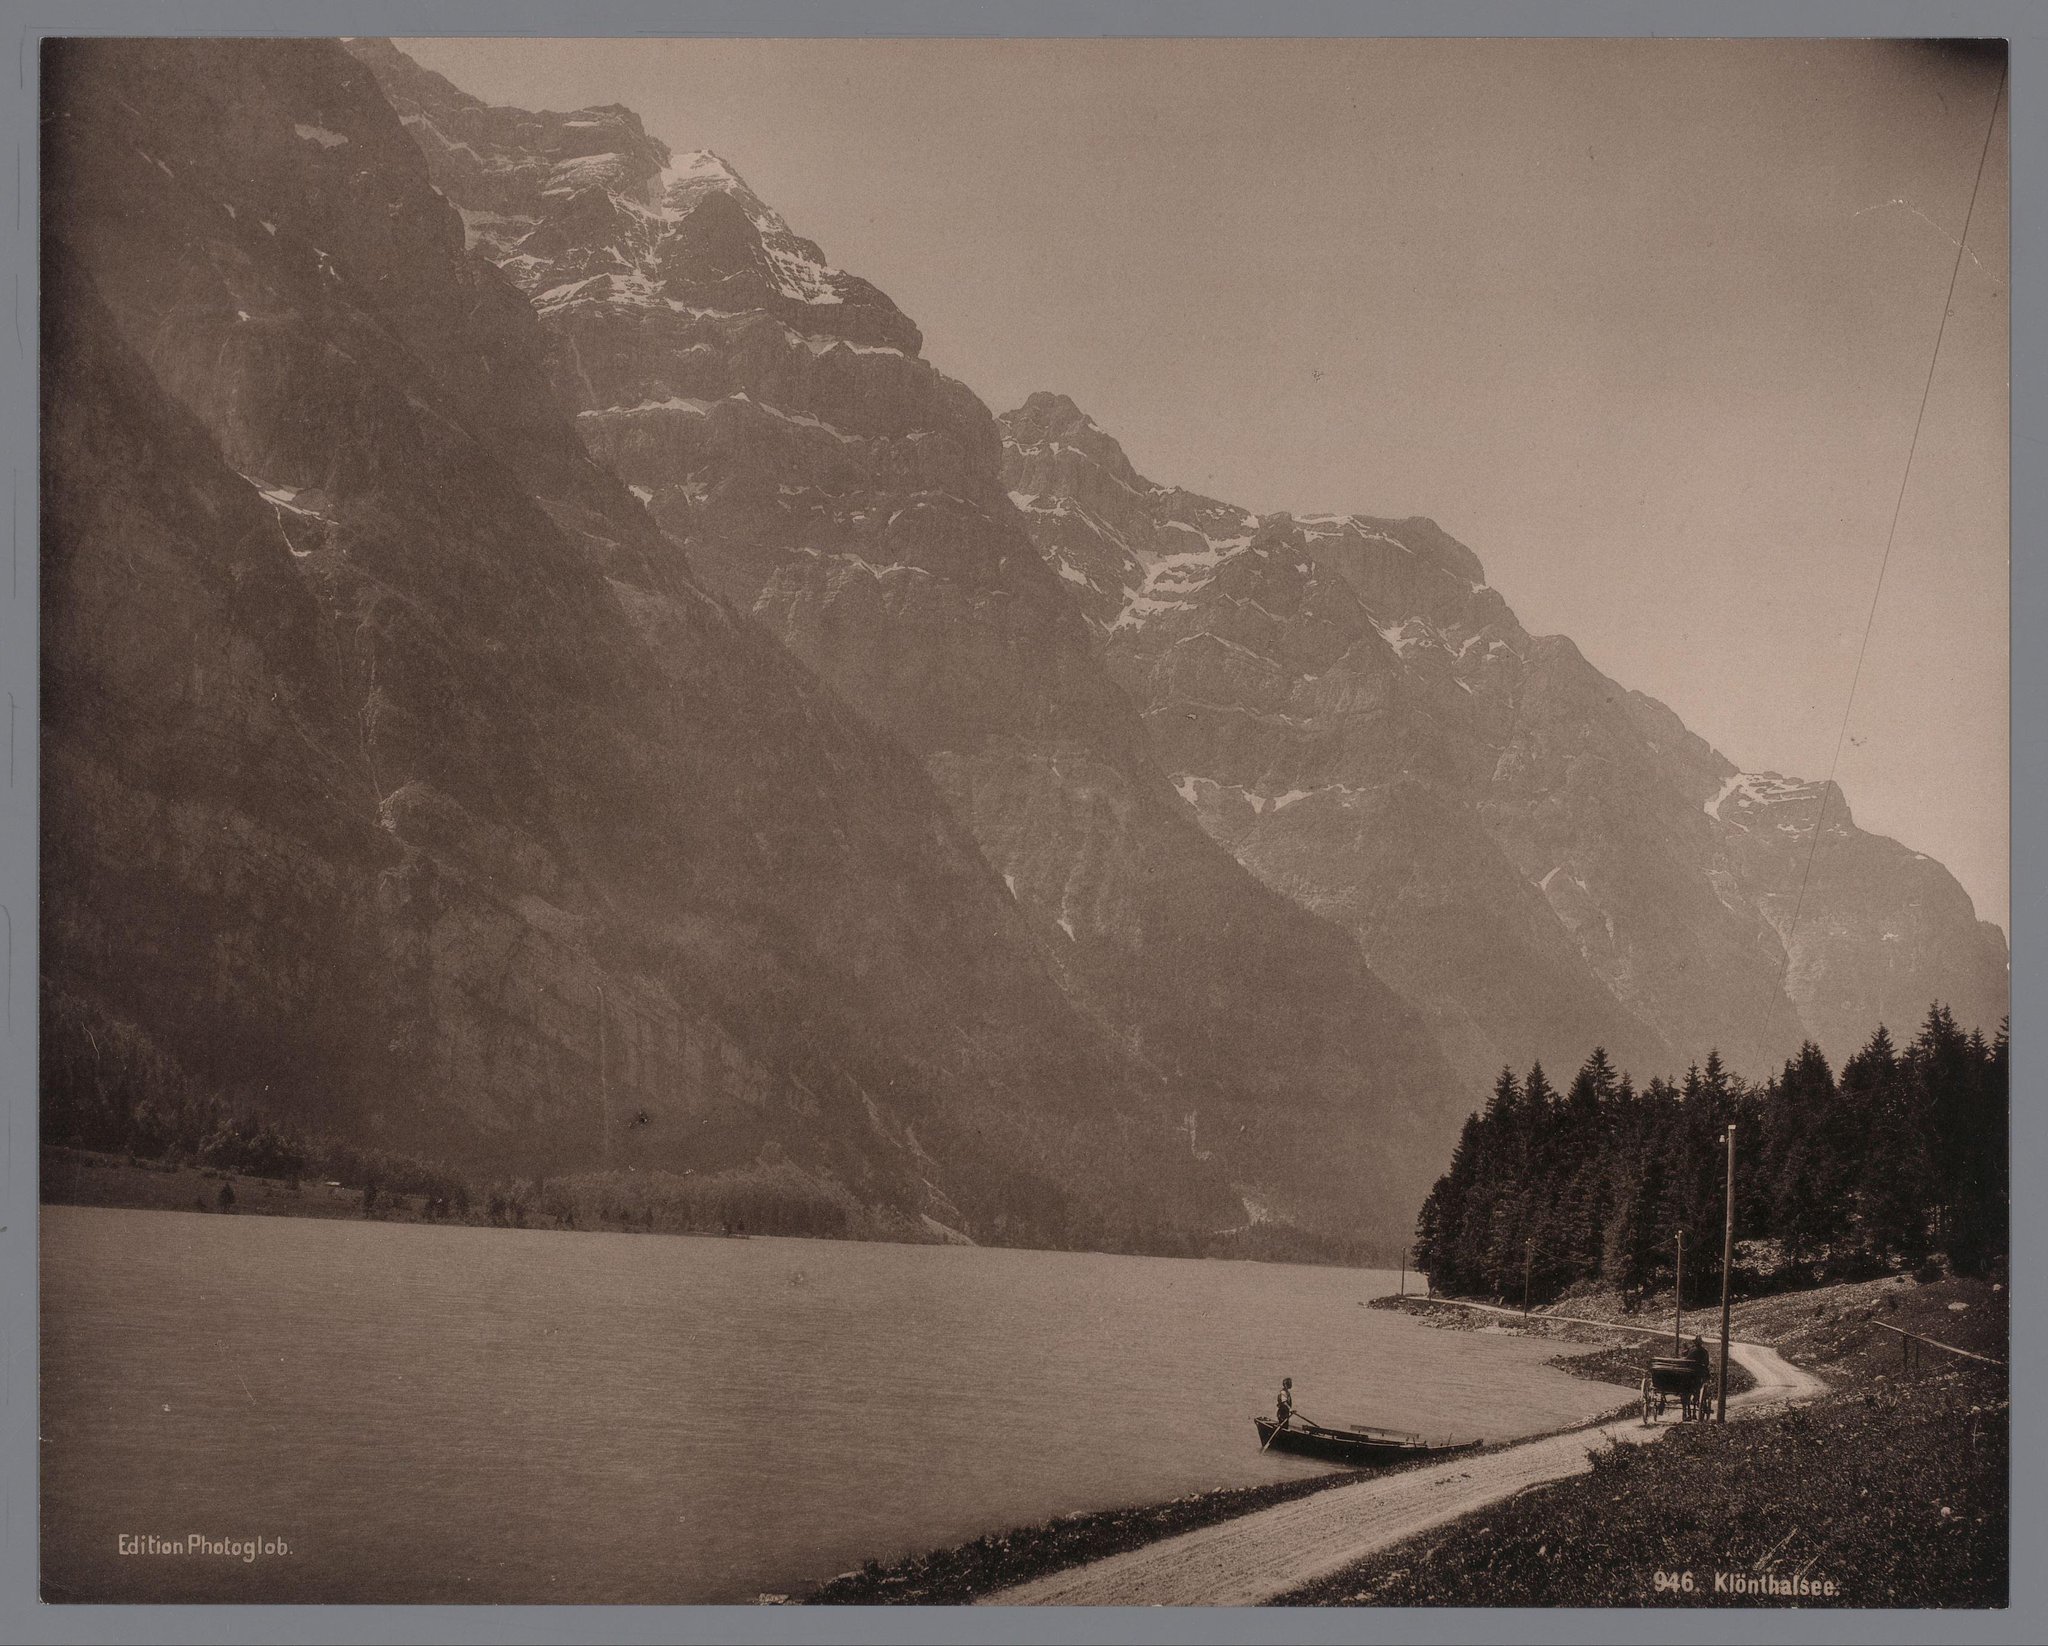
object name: photograph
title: Klönthalsee, Zwitserland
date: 1890-1925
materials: paper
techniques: collodion silver print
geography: switzerland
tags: switzerland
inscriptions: inscription: ‘EditionPhotoglob.’, inscription: ‘946. Klönthalsee.’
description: Gezicht op het meer 'Klönthalsee' (kanton Glarus). met rechts op een weg een koets, en op het water een roeiboot met roeier. Gletsjers op de achtergrond.